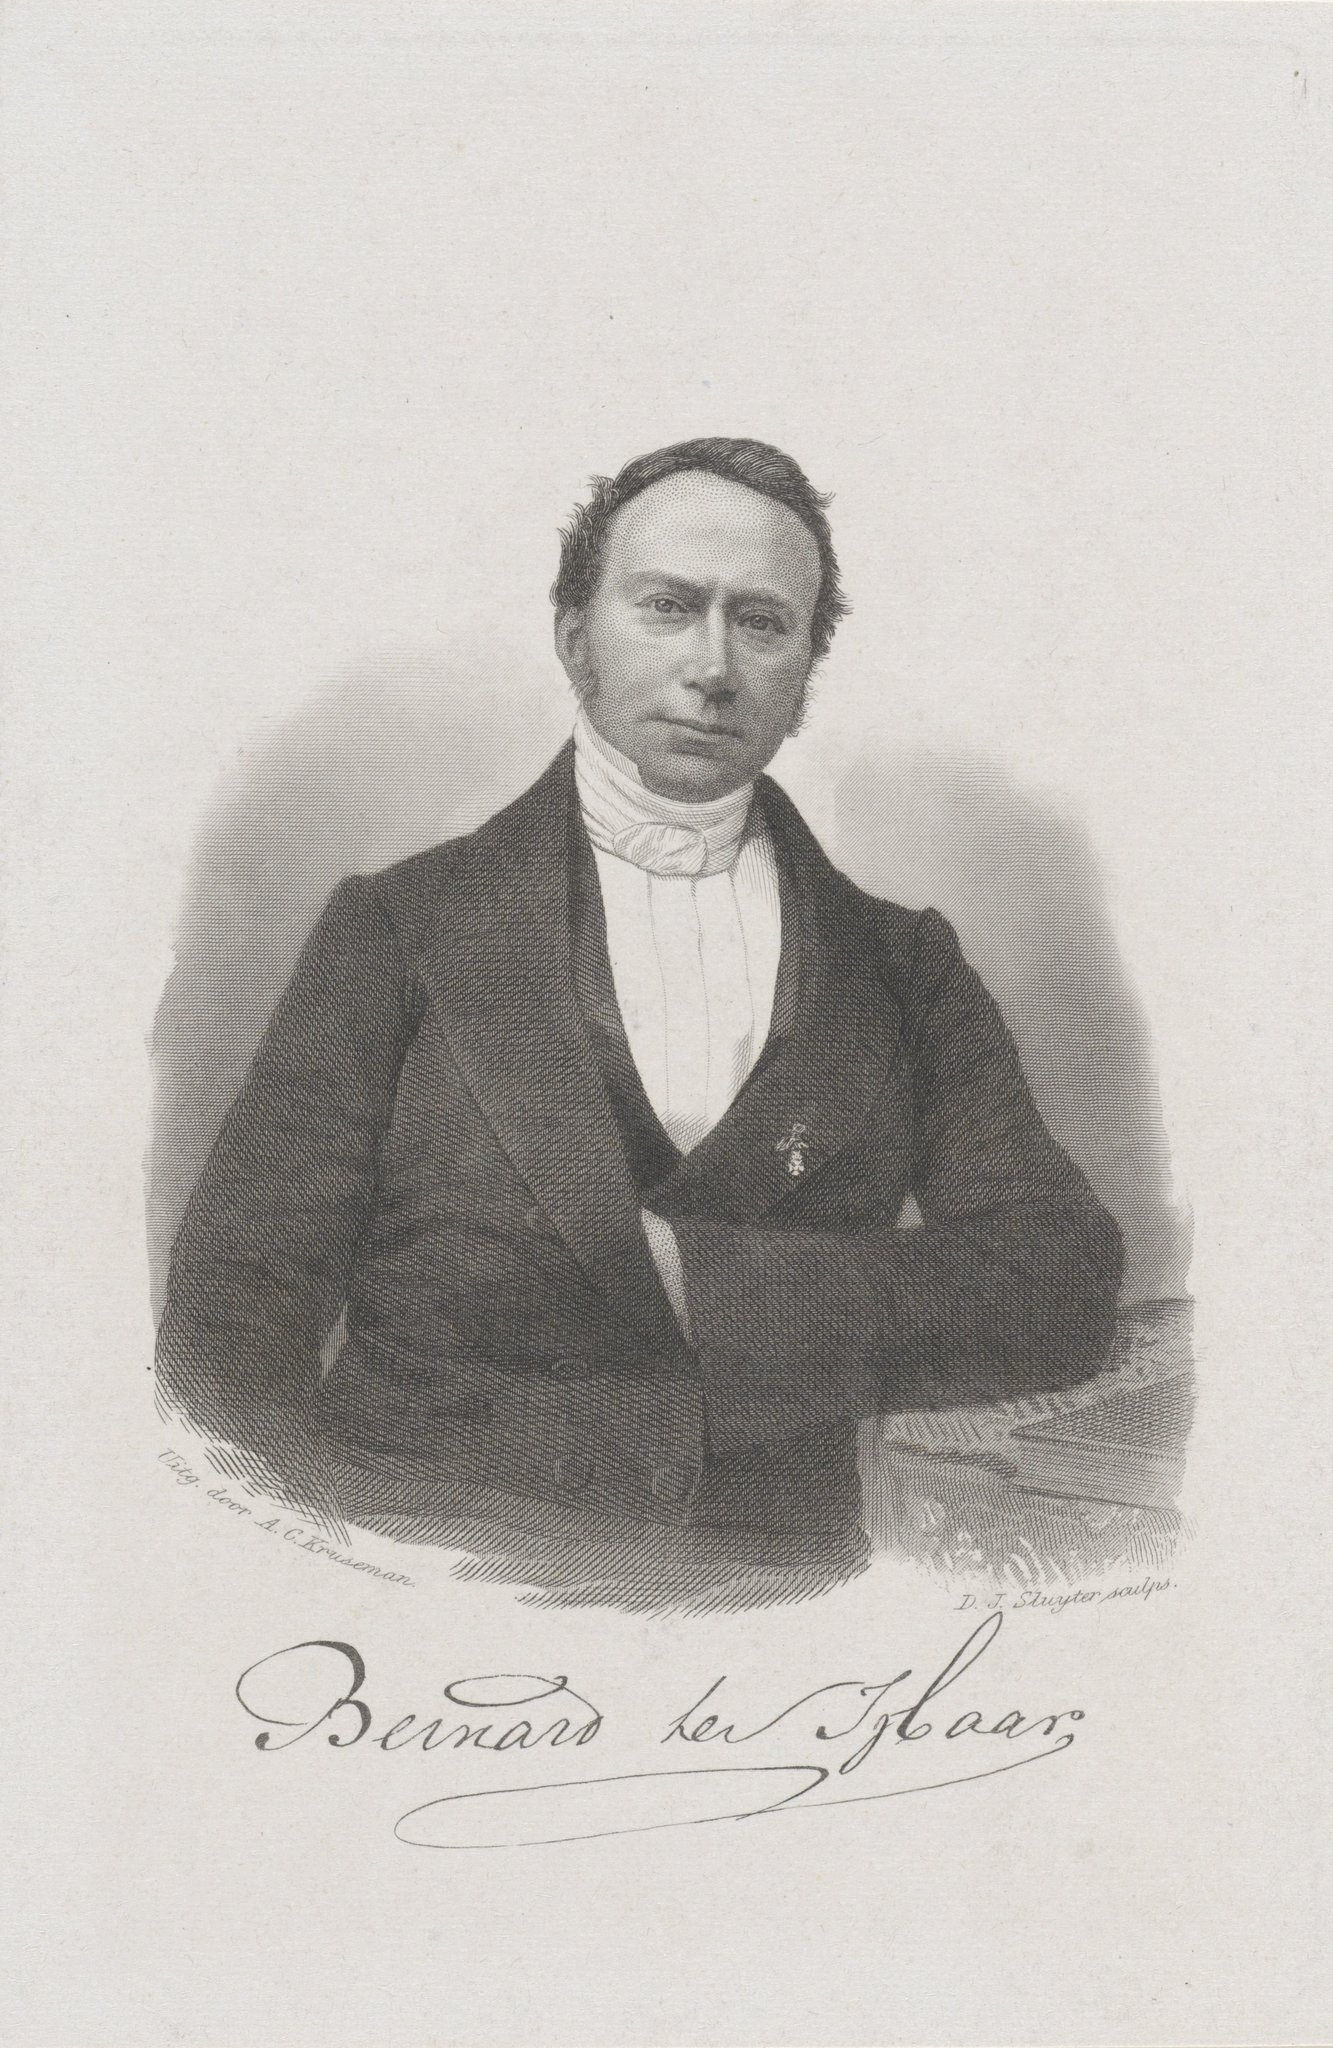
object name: print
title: Portret van de predikant en dichter Bernard ter Haar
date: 1842-1873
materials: paper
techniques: etching, engraving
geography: haarlem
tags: amsterdam, bernard ter haar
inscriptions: collector's mark: Lugt 2228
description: Gebruikt als illustratie in: Aurora; jaarboekjen voor 1857. Haarlem: A.C. Kruseman, 1857.